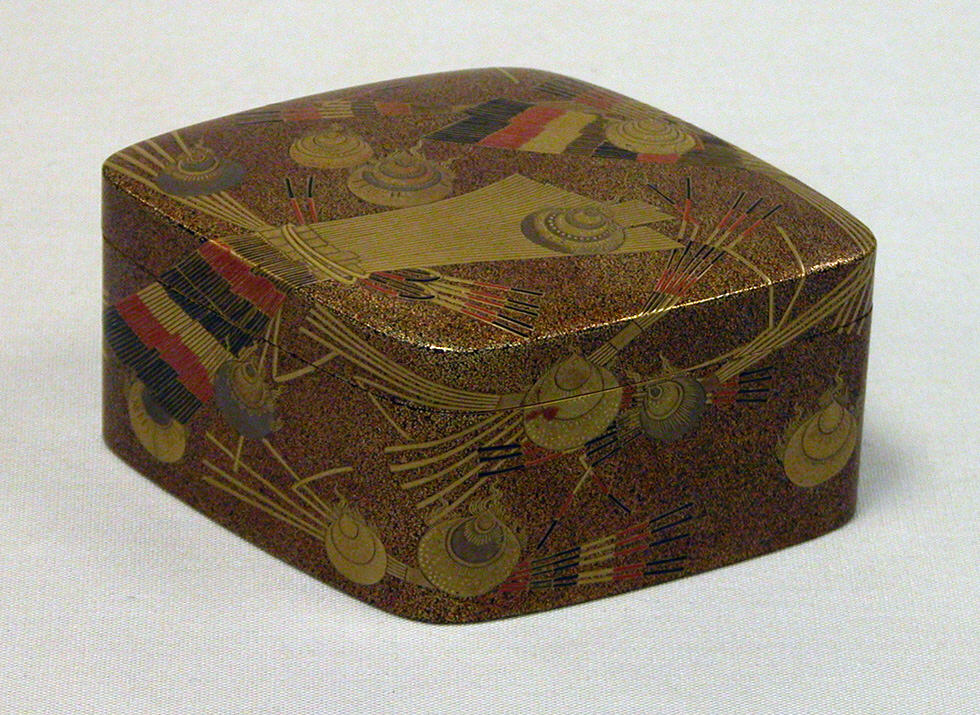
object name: kobako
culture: japanese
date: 1601-1700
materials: gold, lacquer